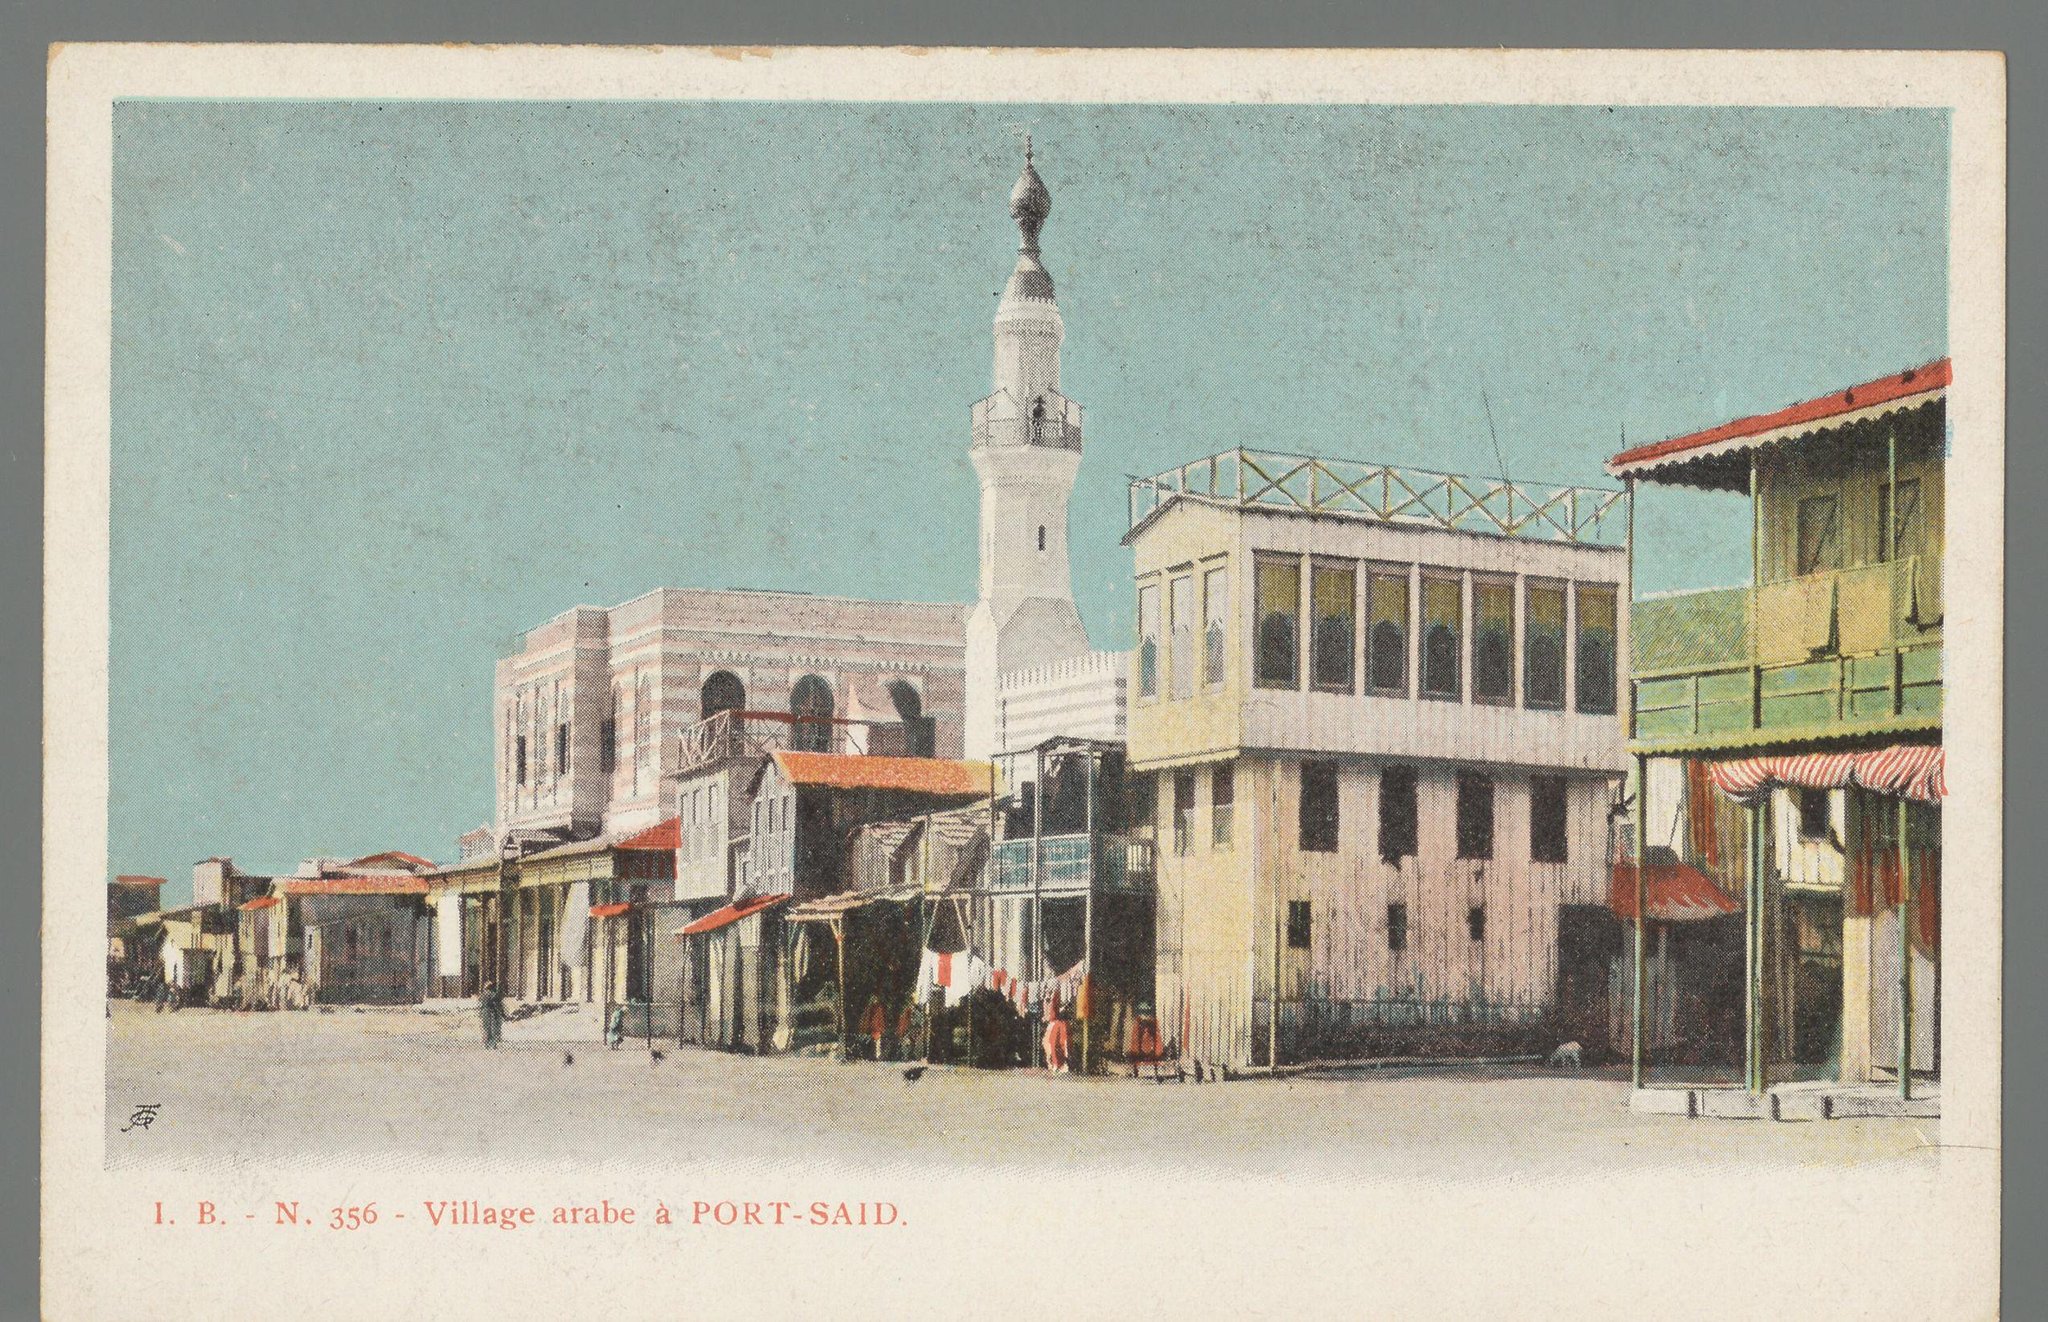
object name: ansichtkaart, prentbriefkaart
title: Village arabe à Port-Said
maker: Anonymous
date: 1907-1930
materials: cardboard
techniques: lithograph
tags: temple, shrine ~ islam, mohammedanism, street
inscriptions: inscription: ‘I. B. - N.’, monogram: ‘AG’